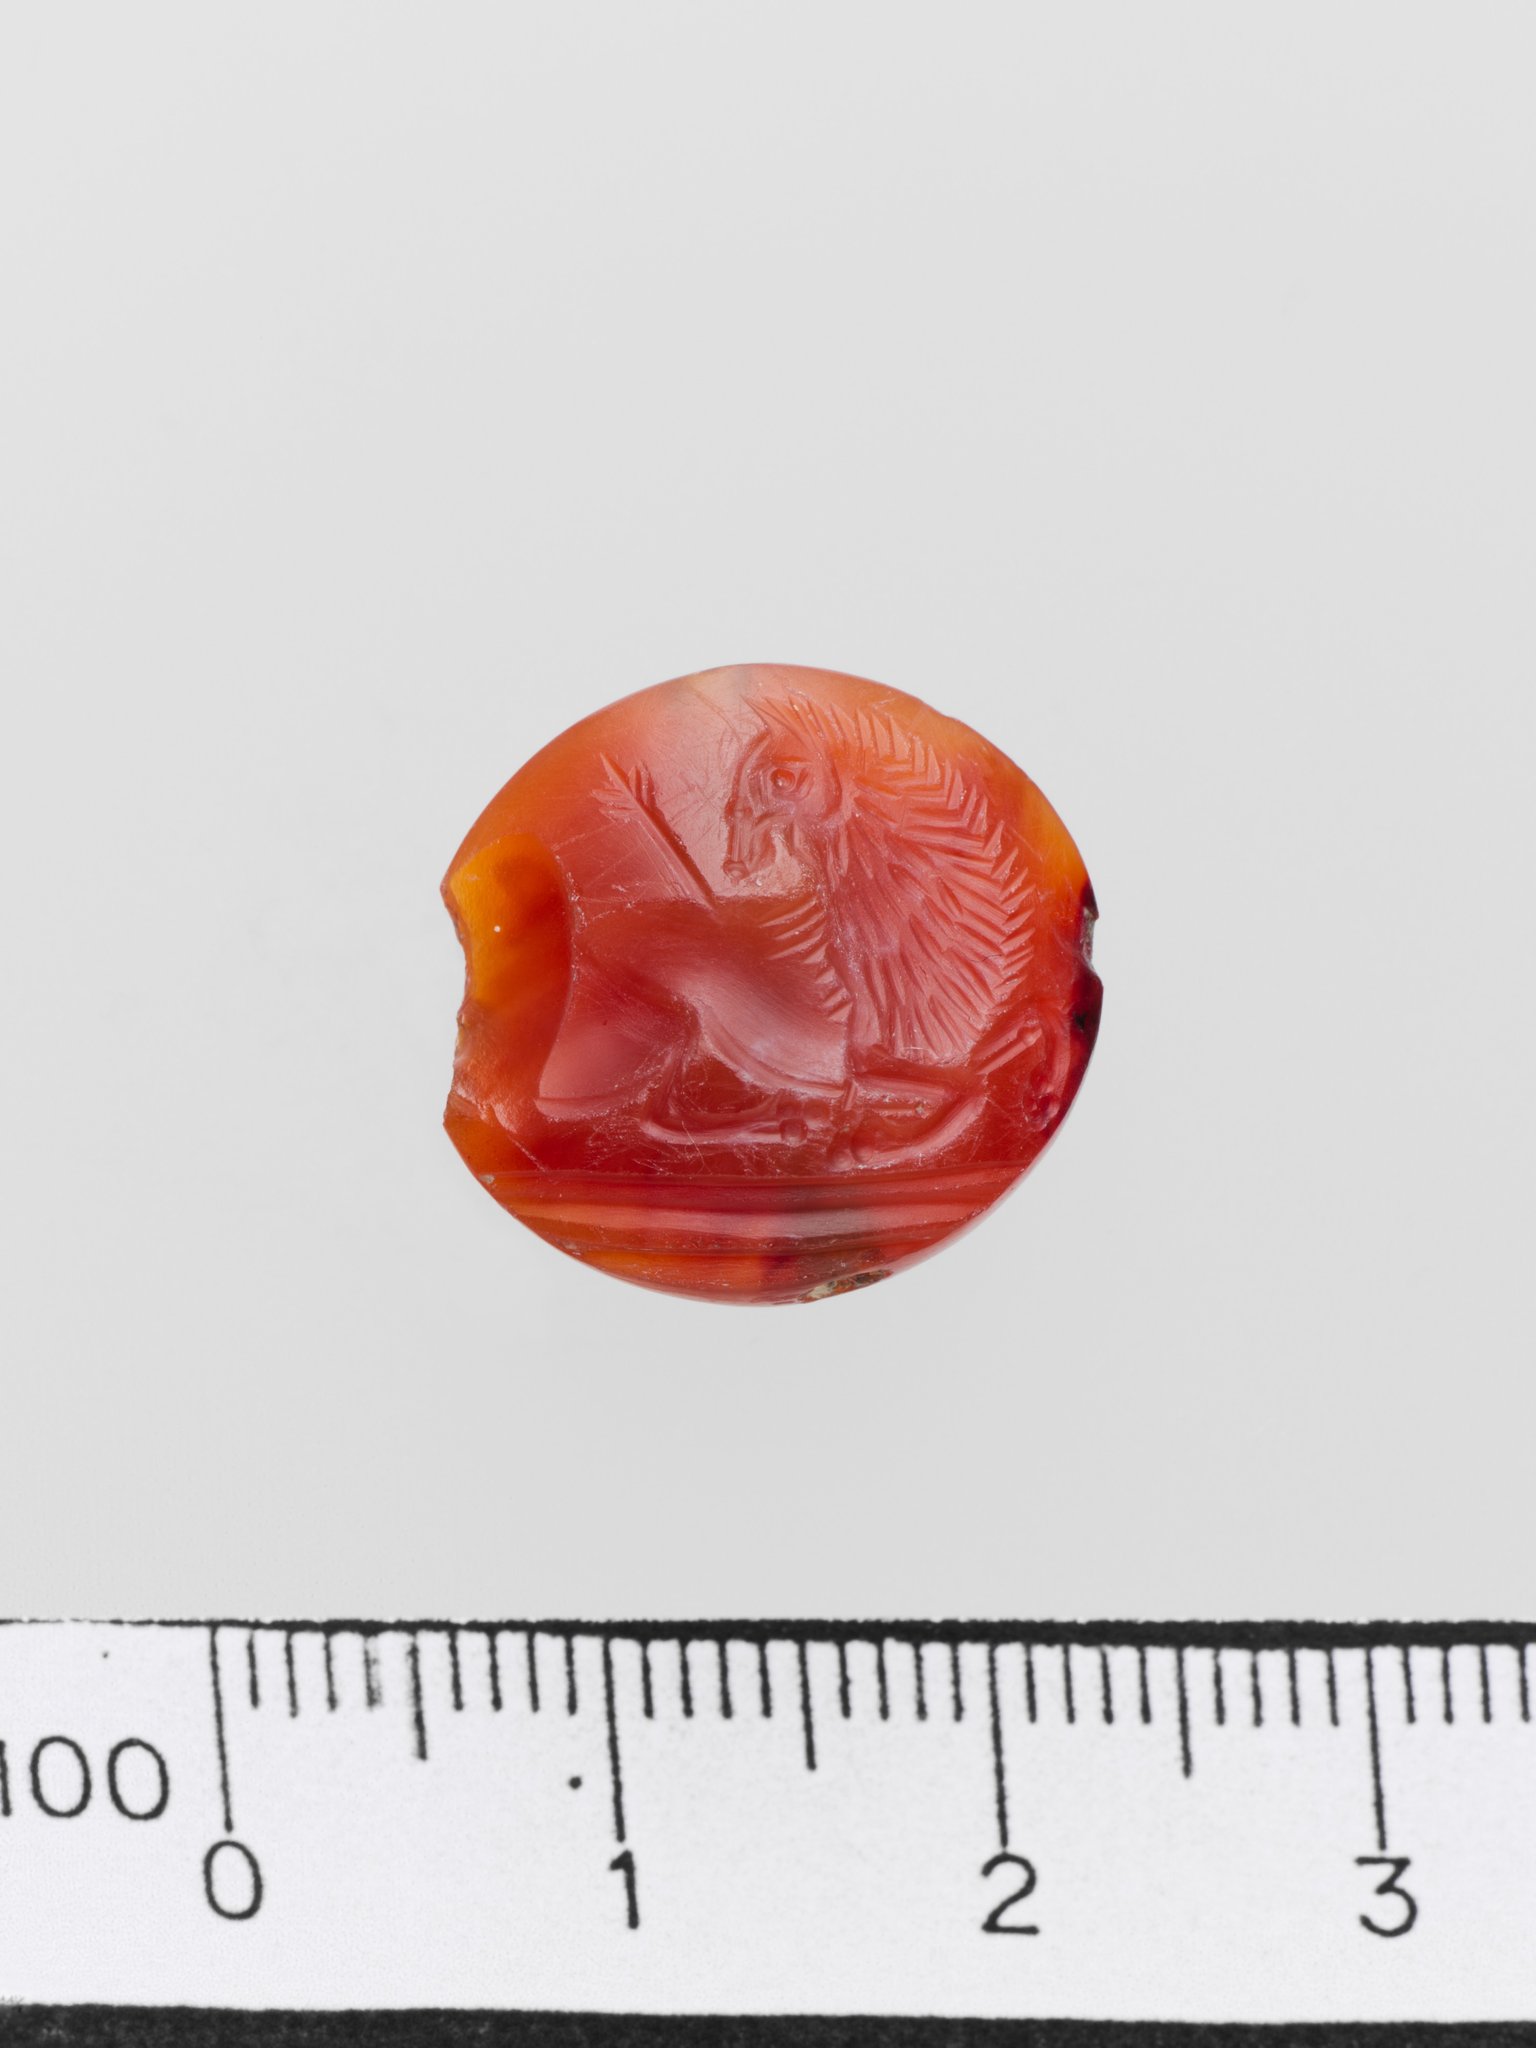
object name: seal, lentoid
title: Carnelian lentoid seal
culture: minoan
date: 1600-1400 BCE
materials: gemstone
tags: arrows,lions